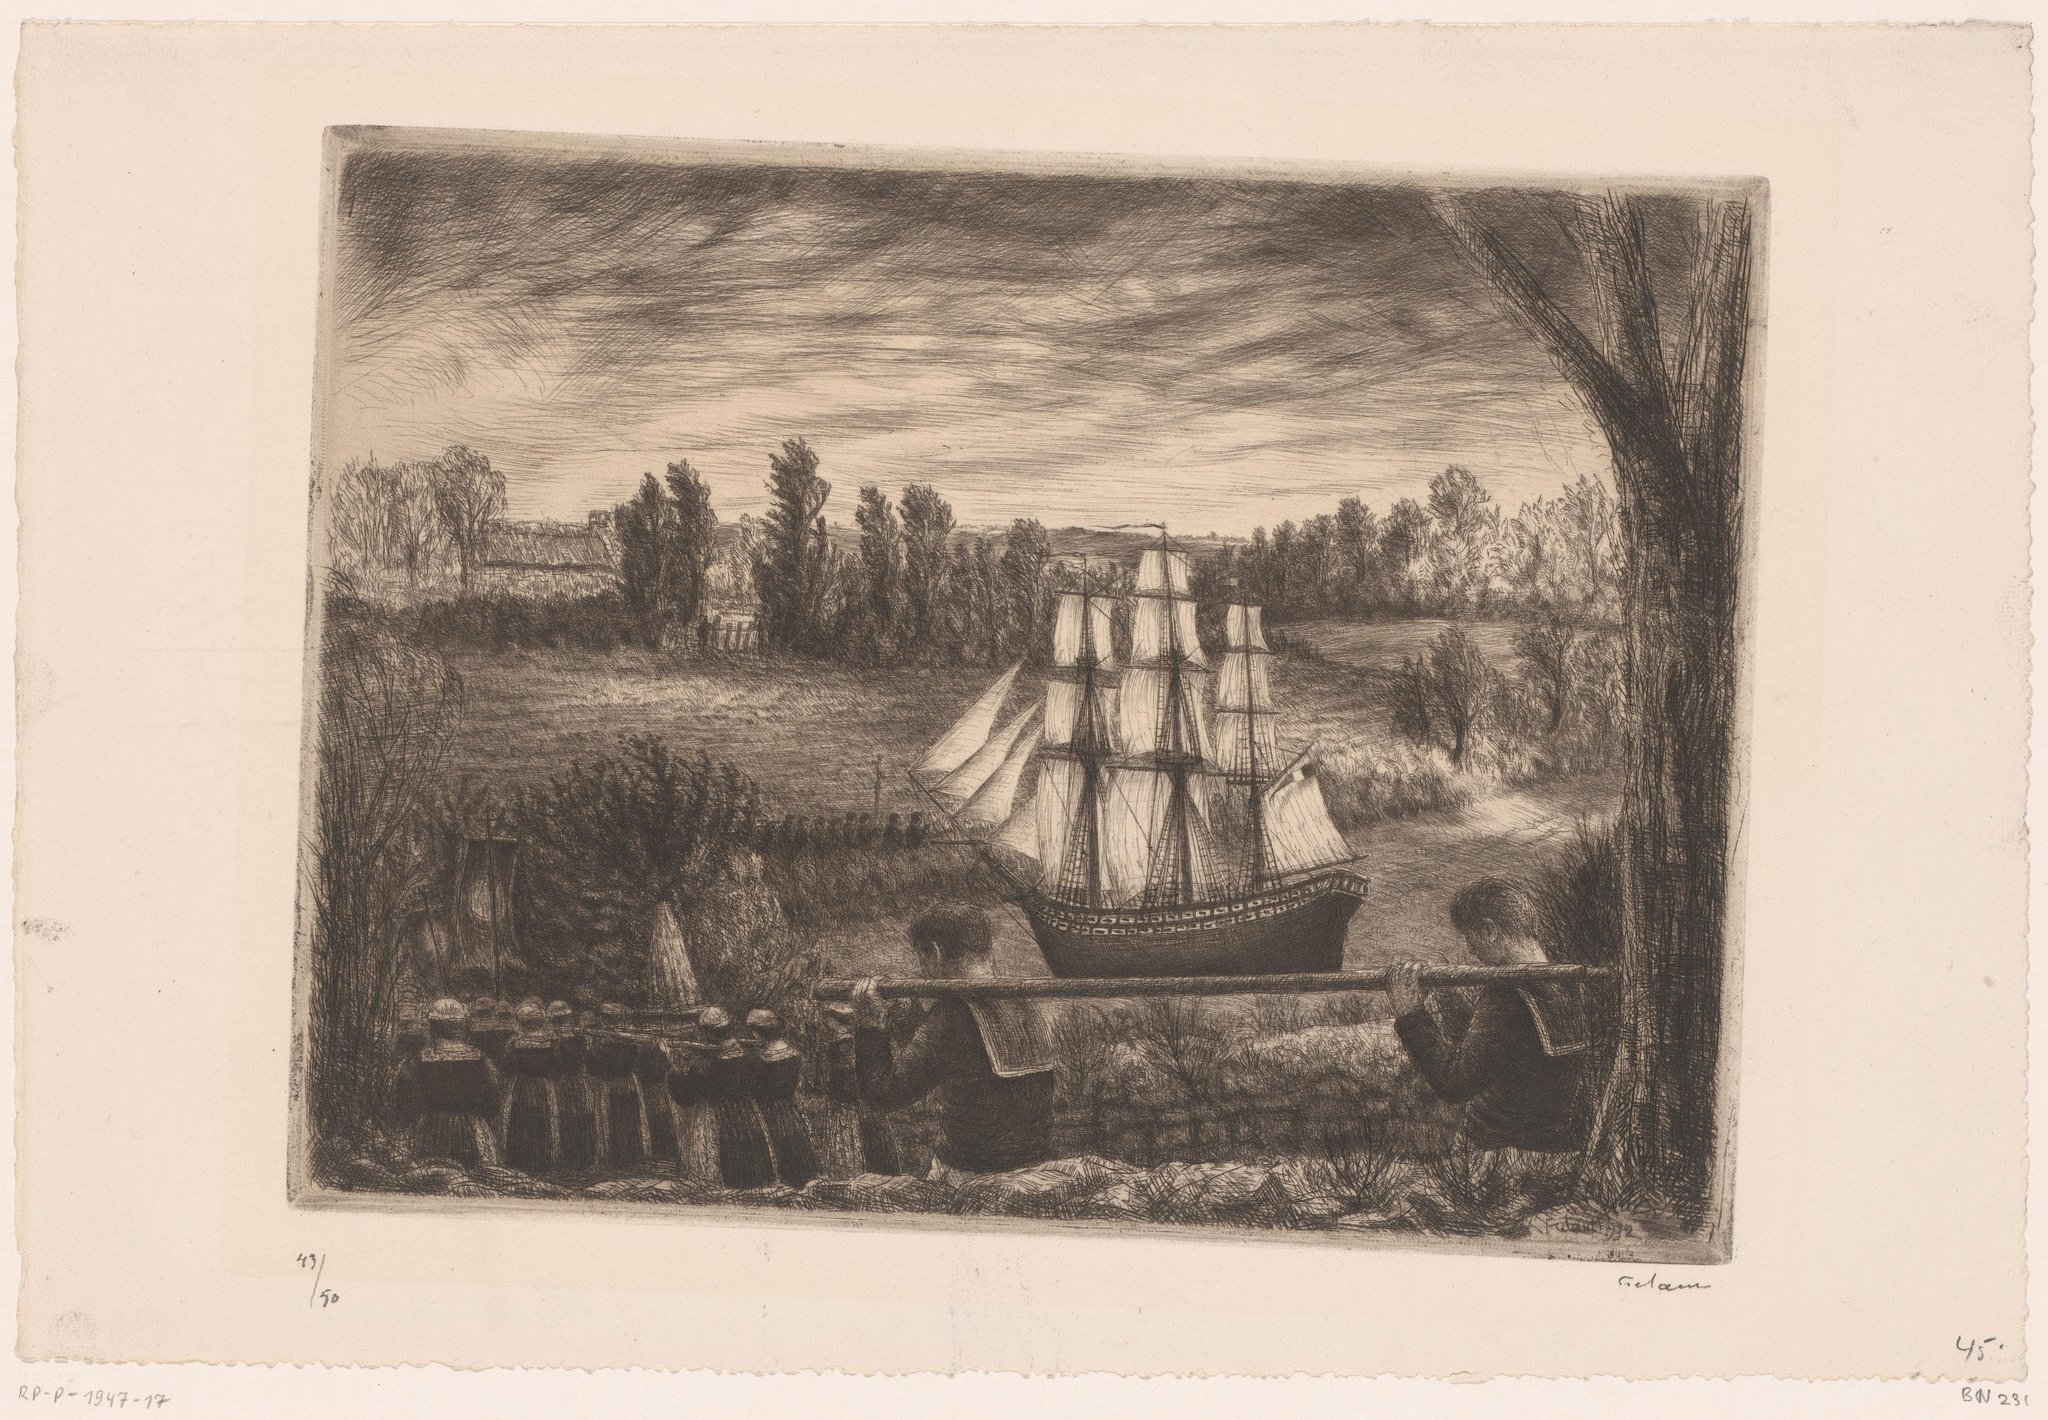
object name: print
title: Processie met modelschepen in een landschap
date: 1932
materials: paper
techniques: drypoint, etching, intaglio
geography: france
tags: landscapes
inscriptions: check stamp: Lugt 2254, collector's mark: Lugt 2228, watermark